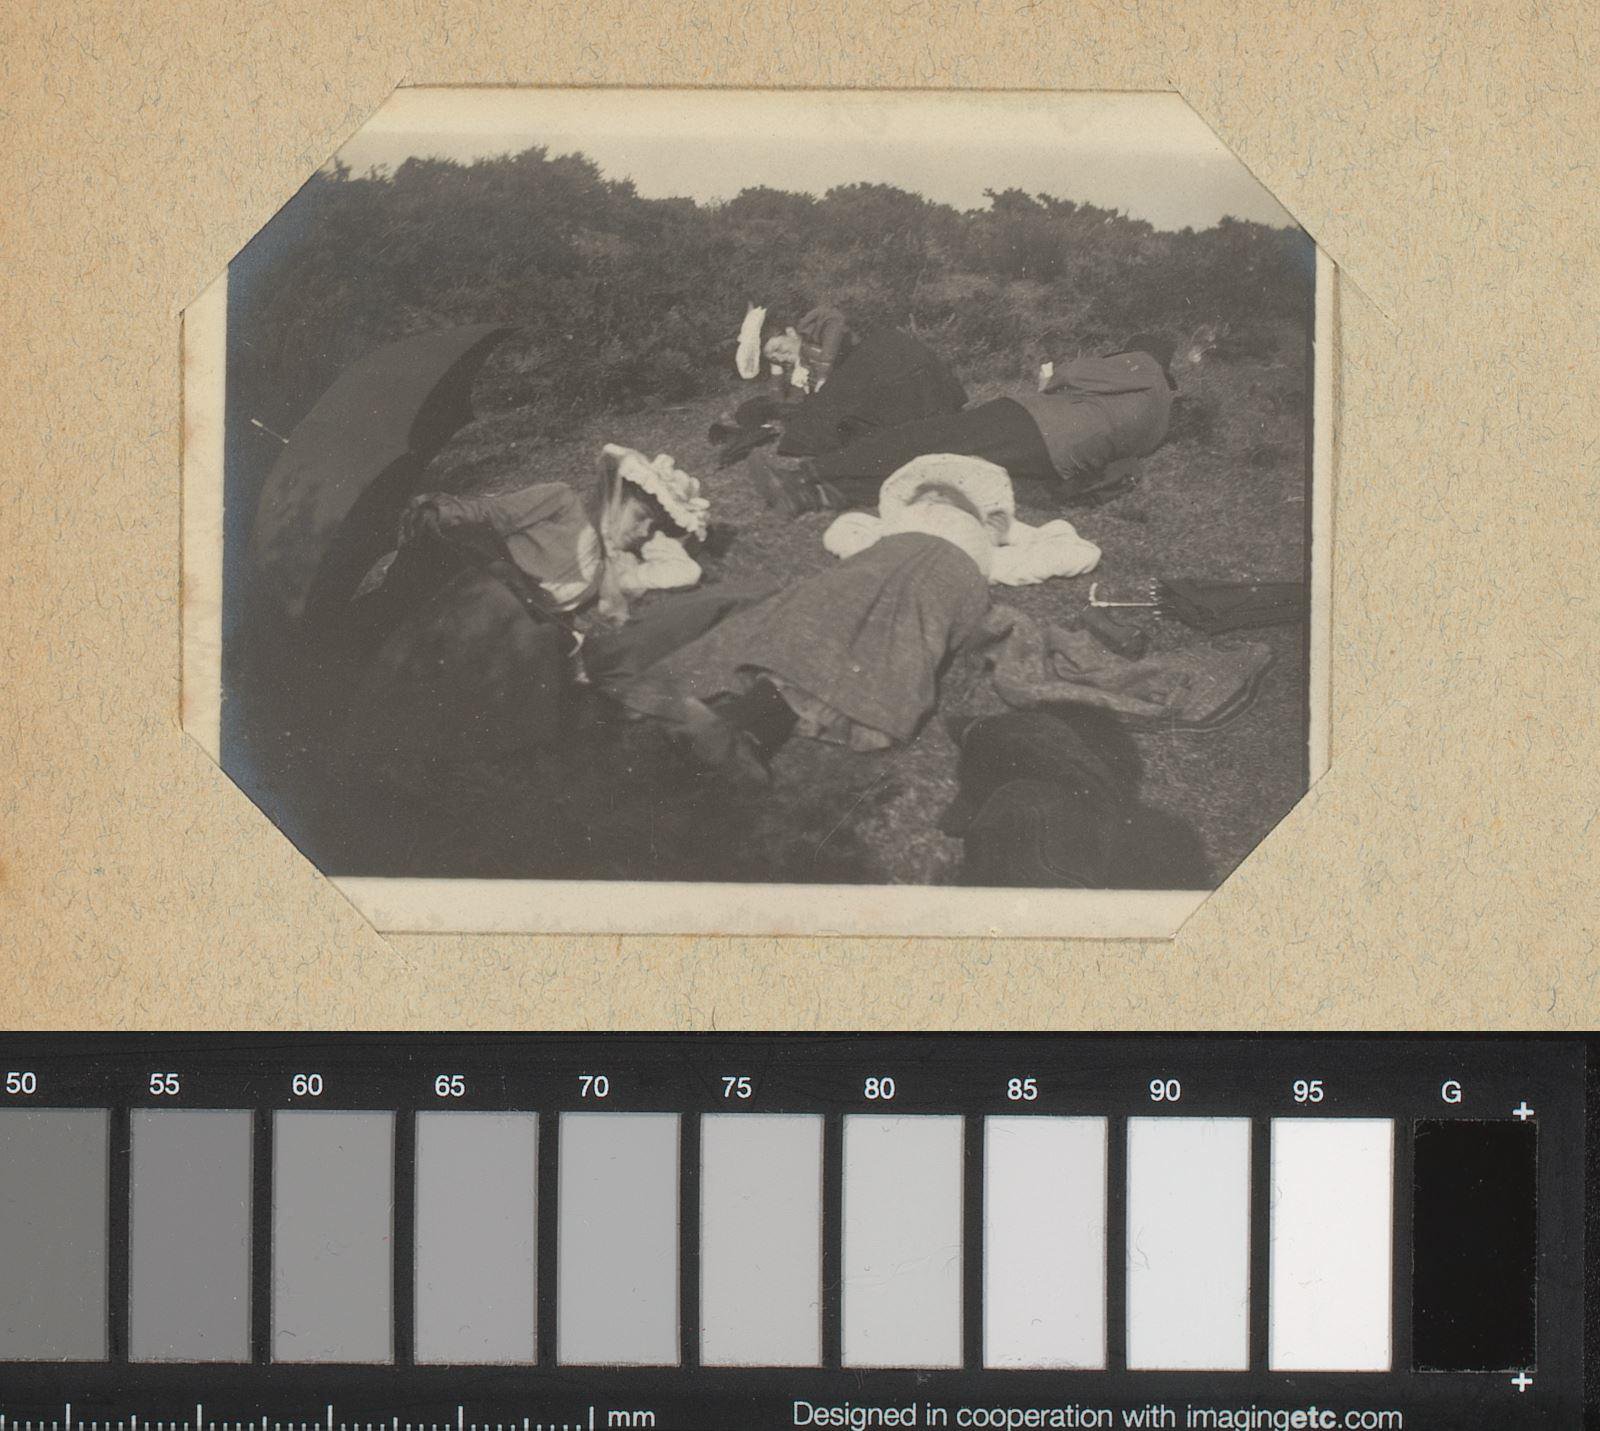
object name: photograph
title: Vrouwen liggend in een veld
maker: Anonymous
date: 1897-1900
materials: paper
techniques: gelatin silver print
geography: france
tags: sleeping on the ground - bb - out of doors, france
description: Over de foto is een ander negatief afgedrukt van een voorstelling van bomen.